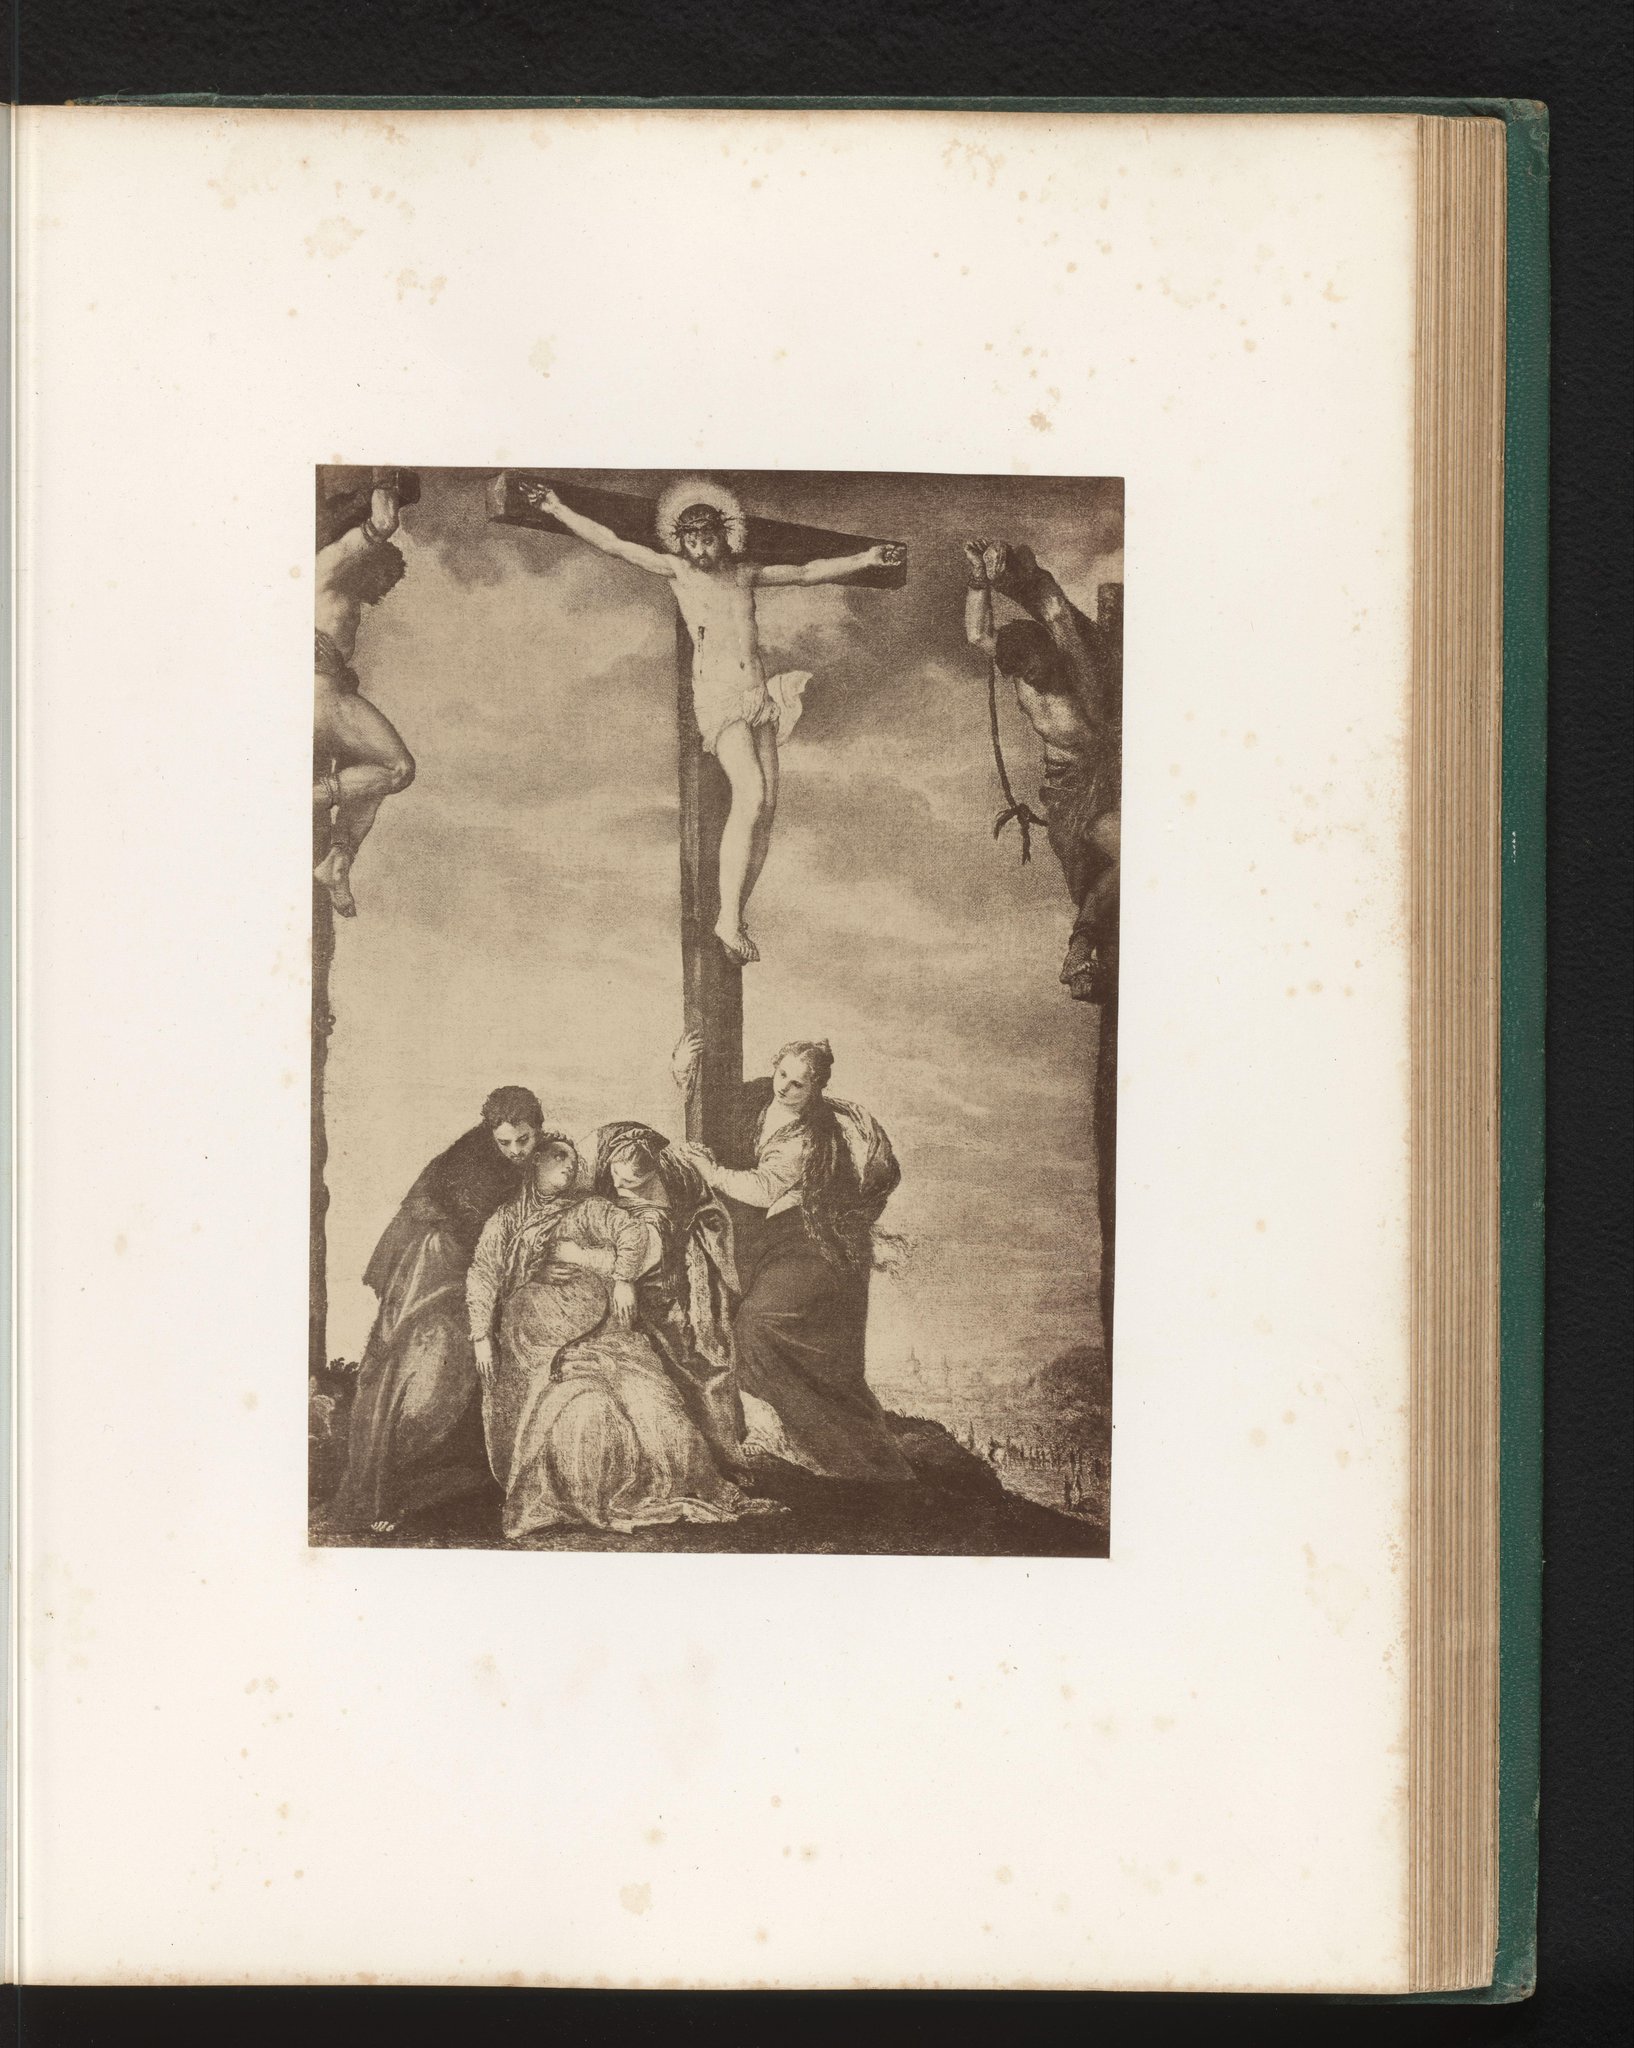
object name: reproduction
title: P. Veronese: Christus am Kreuz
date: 1870-1875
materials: paper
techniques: albumen print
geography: berlin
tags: crucified christ with mary, john, and mary magdalene - dd - the three crosses